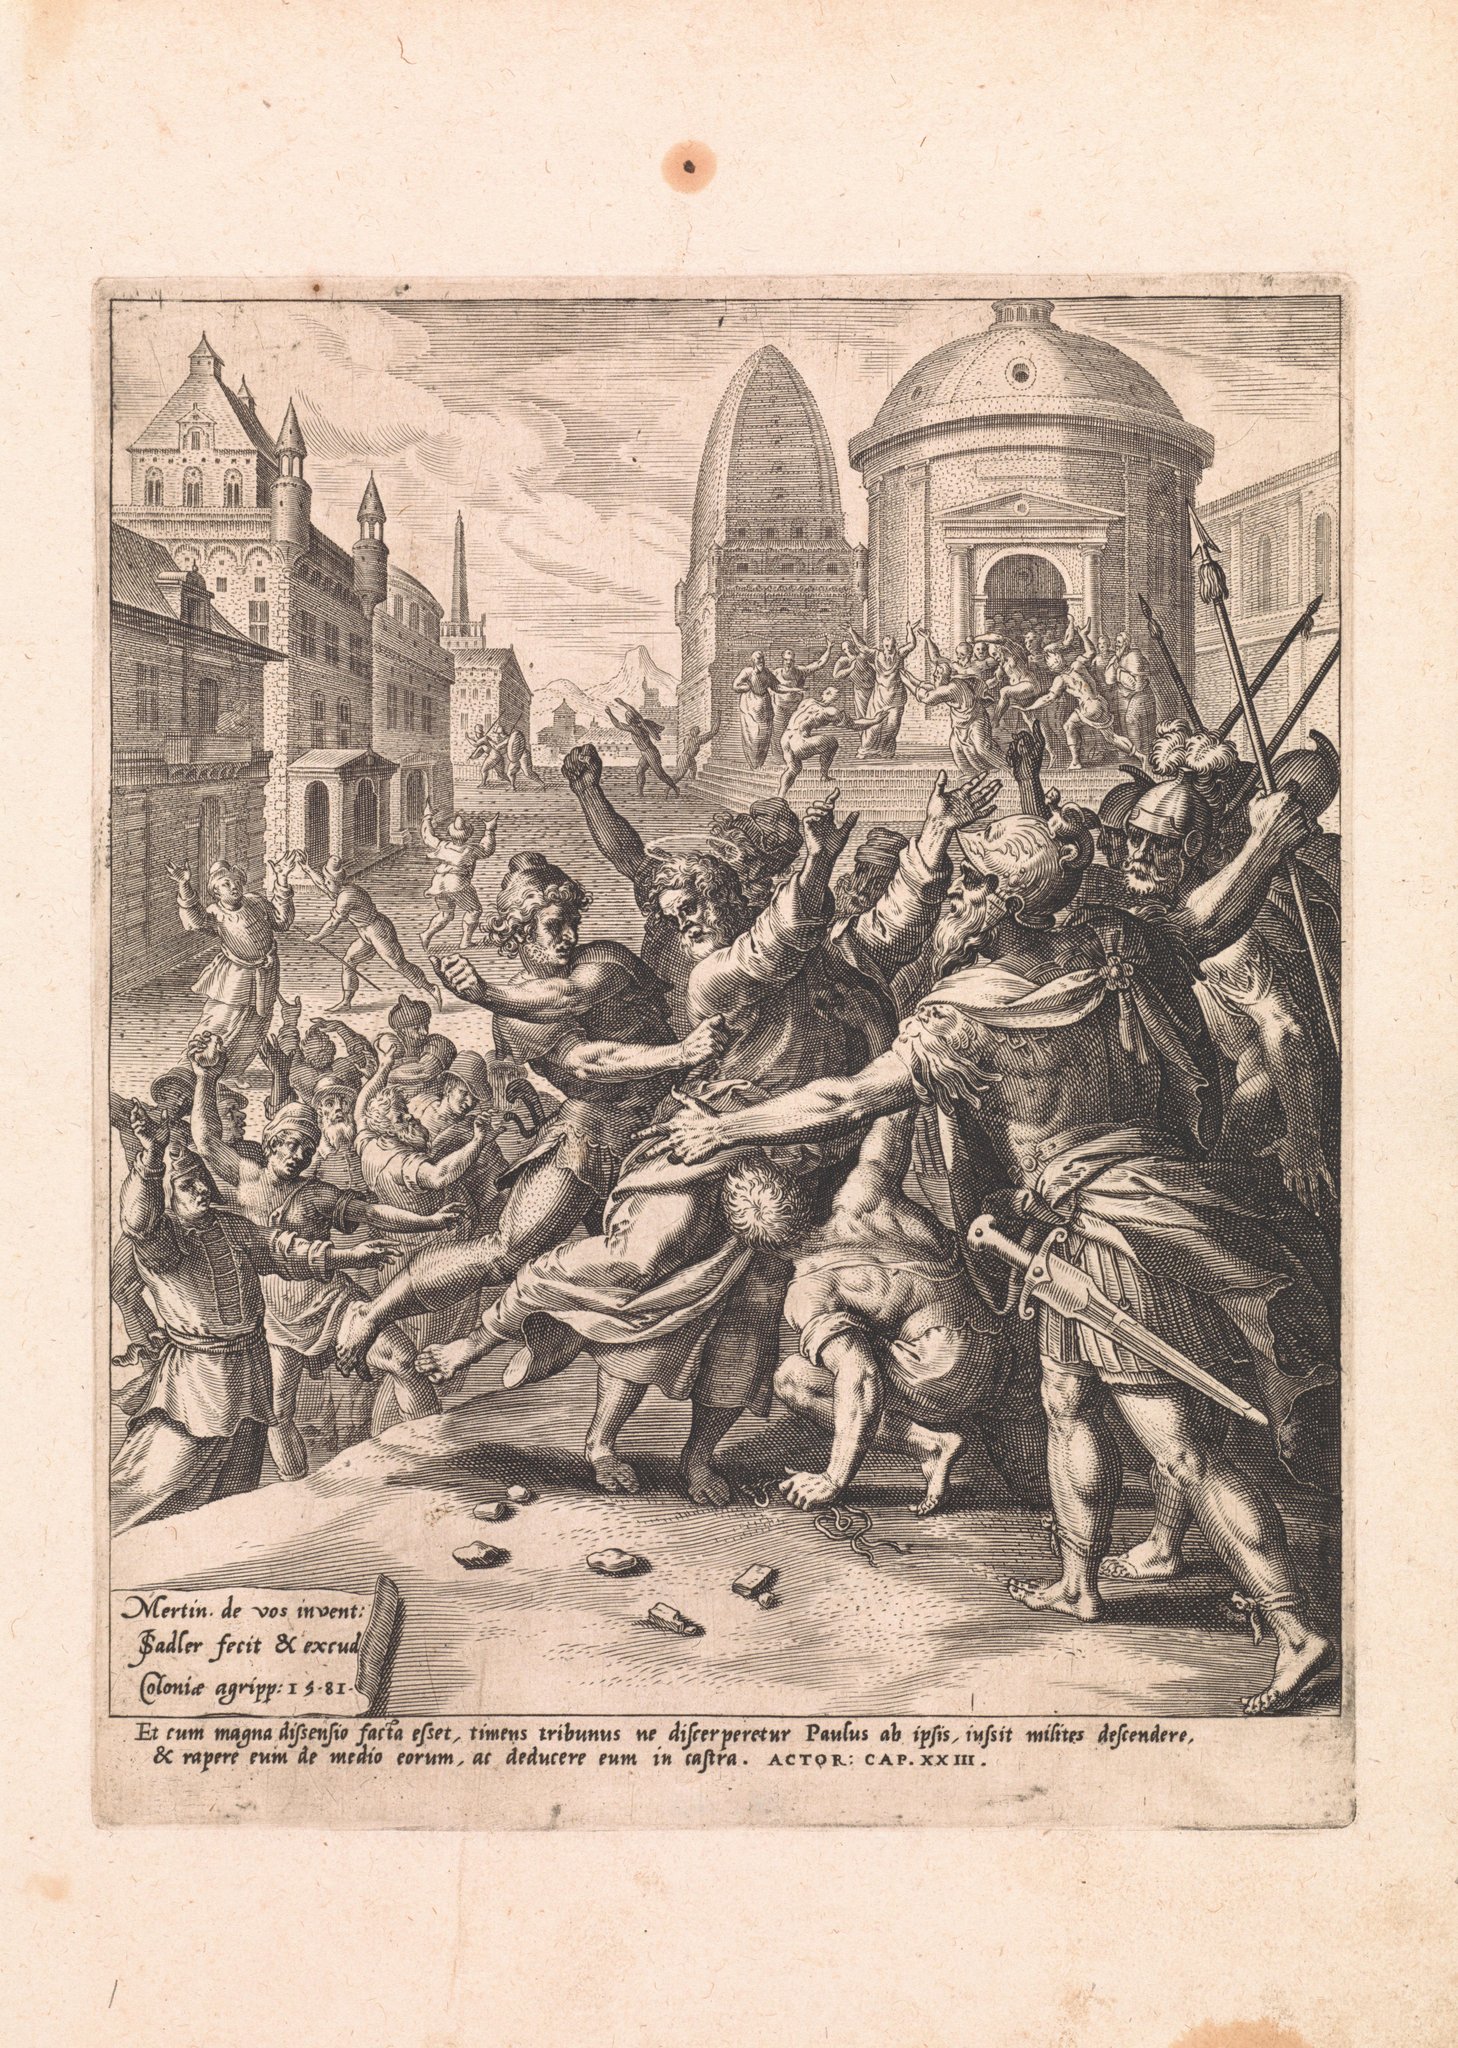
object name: print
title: Paulus wordt door de joden aangevallen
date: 1581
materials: paper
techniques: engraving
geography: cologne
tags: paul speaks to the people from the stairs, paul is dragged out of the temple by the jews; he is rescued by soldiers, who arrest him and carry him away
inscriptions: collector's mark: Lugt 2228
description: In Jeruzalem wordt Paulus wordt door de joden aangevallen en met stenen bekogeld. Soldaten komen hem beschermen. Op de achtergrond spreekt Paulus het Joodse volk toe voor de tempel. Met een Latijns onderschrift met een Bijbelpassage uit de Handelingen van de Apostelen (Hand. 23). De tweede prent van een vierdelige serie.